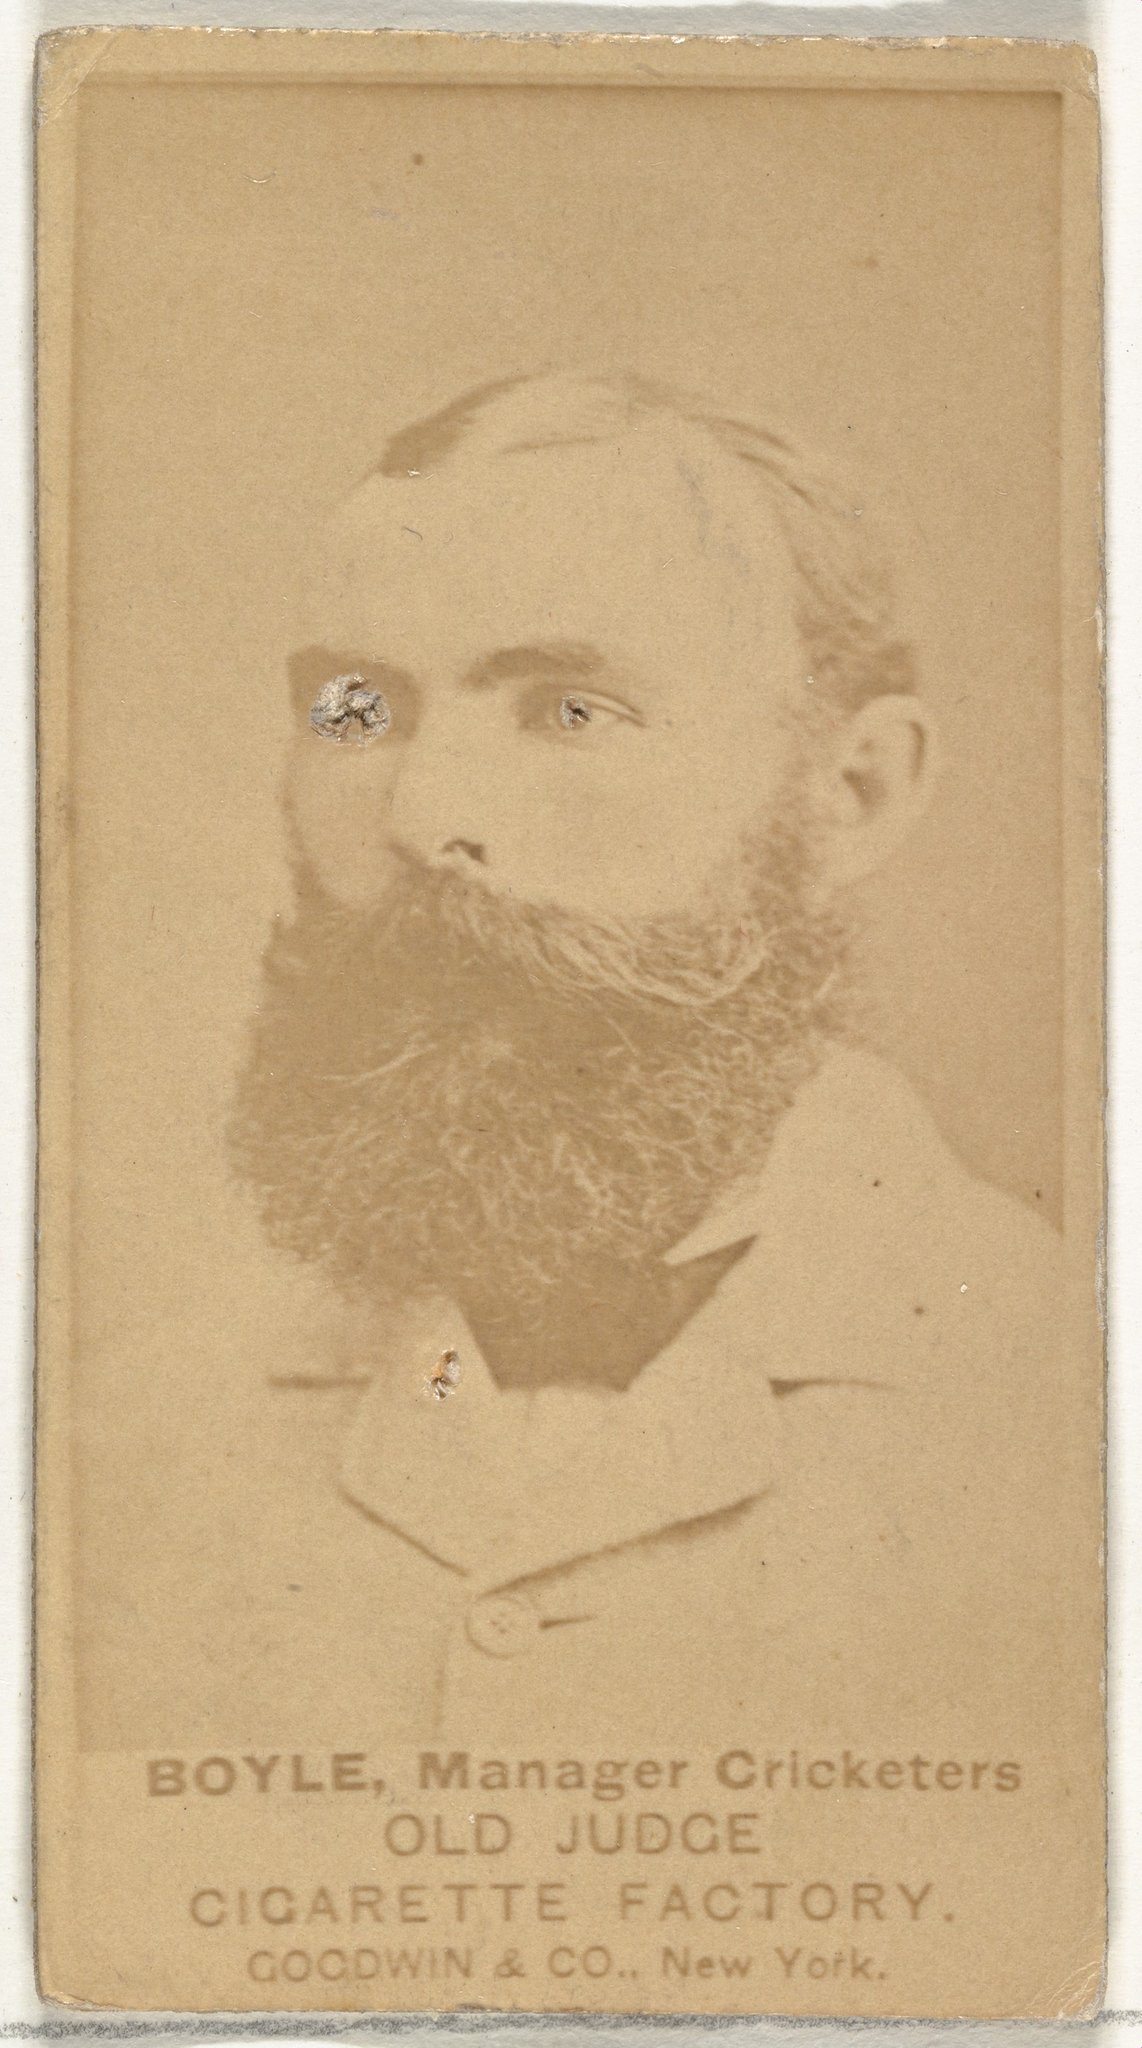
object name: photograph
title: Boyle, Manager of the Cricketers, from the Celebrities and Prizefighters series (N174) for Old Judge Cigarettes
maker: goodwin & company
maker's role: publisher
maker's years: 1850-1950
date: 1887-1888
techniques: albumen silver print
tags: men,portraits,baseball,athletes